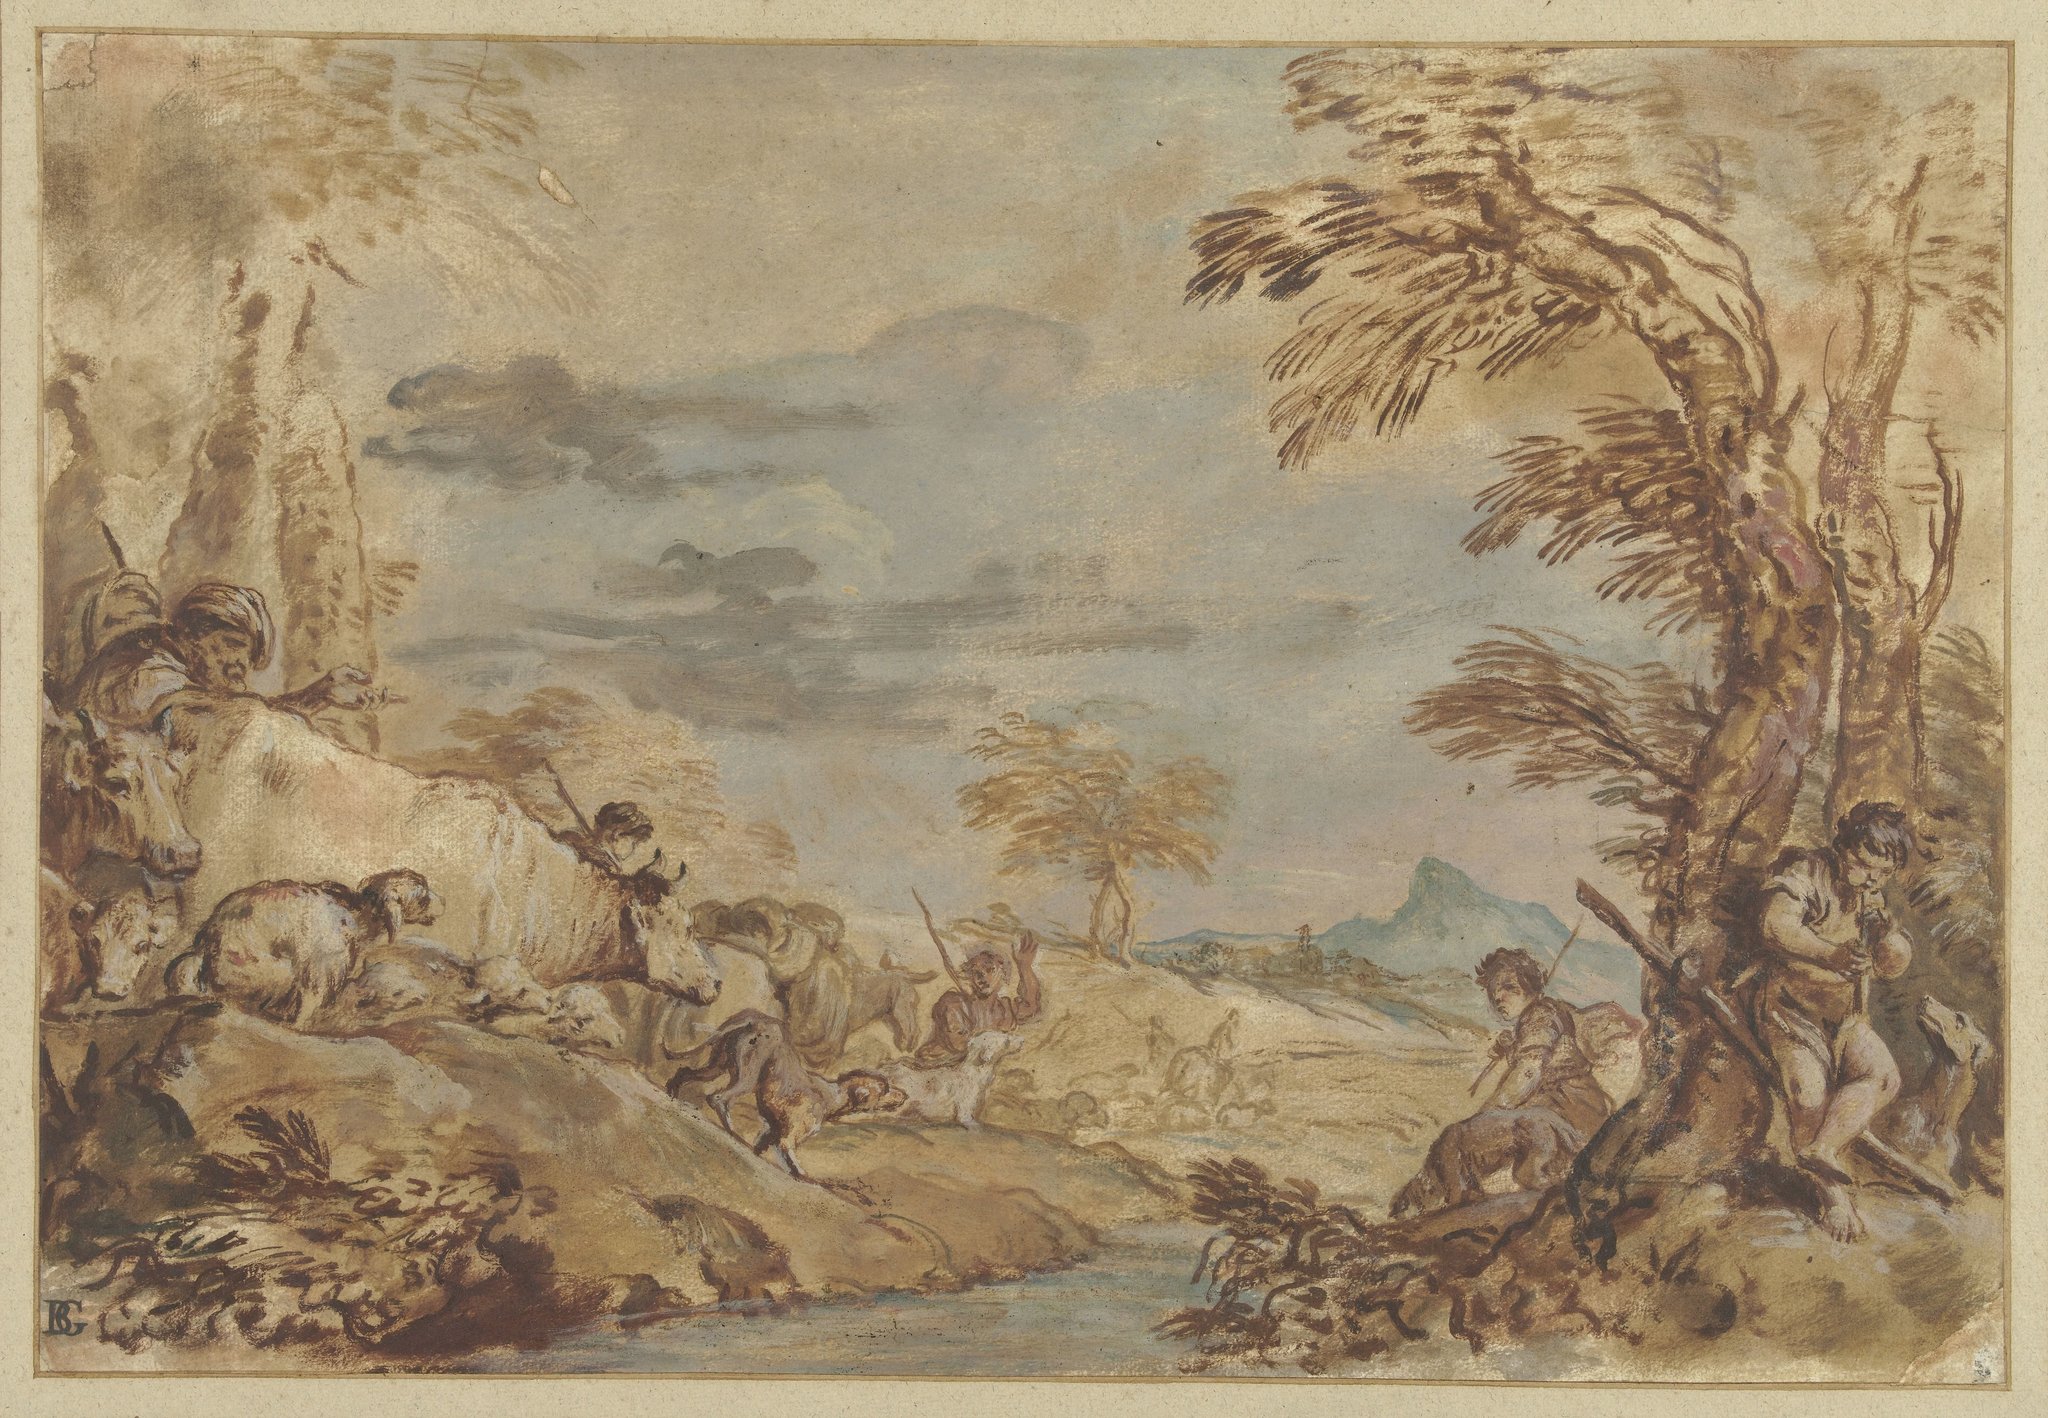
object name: drawing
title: Landschap met voorttrekkende kudden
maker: giovanni benedetto castiglione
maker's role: draughtsman, print maker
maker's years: 1610-1665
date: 1620-1665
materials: oil, paper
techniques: brush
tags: landscapes in the temperate zone, herd, flock